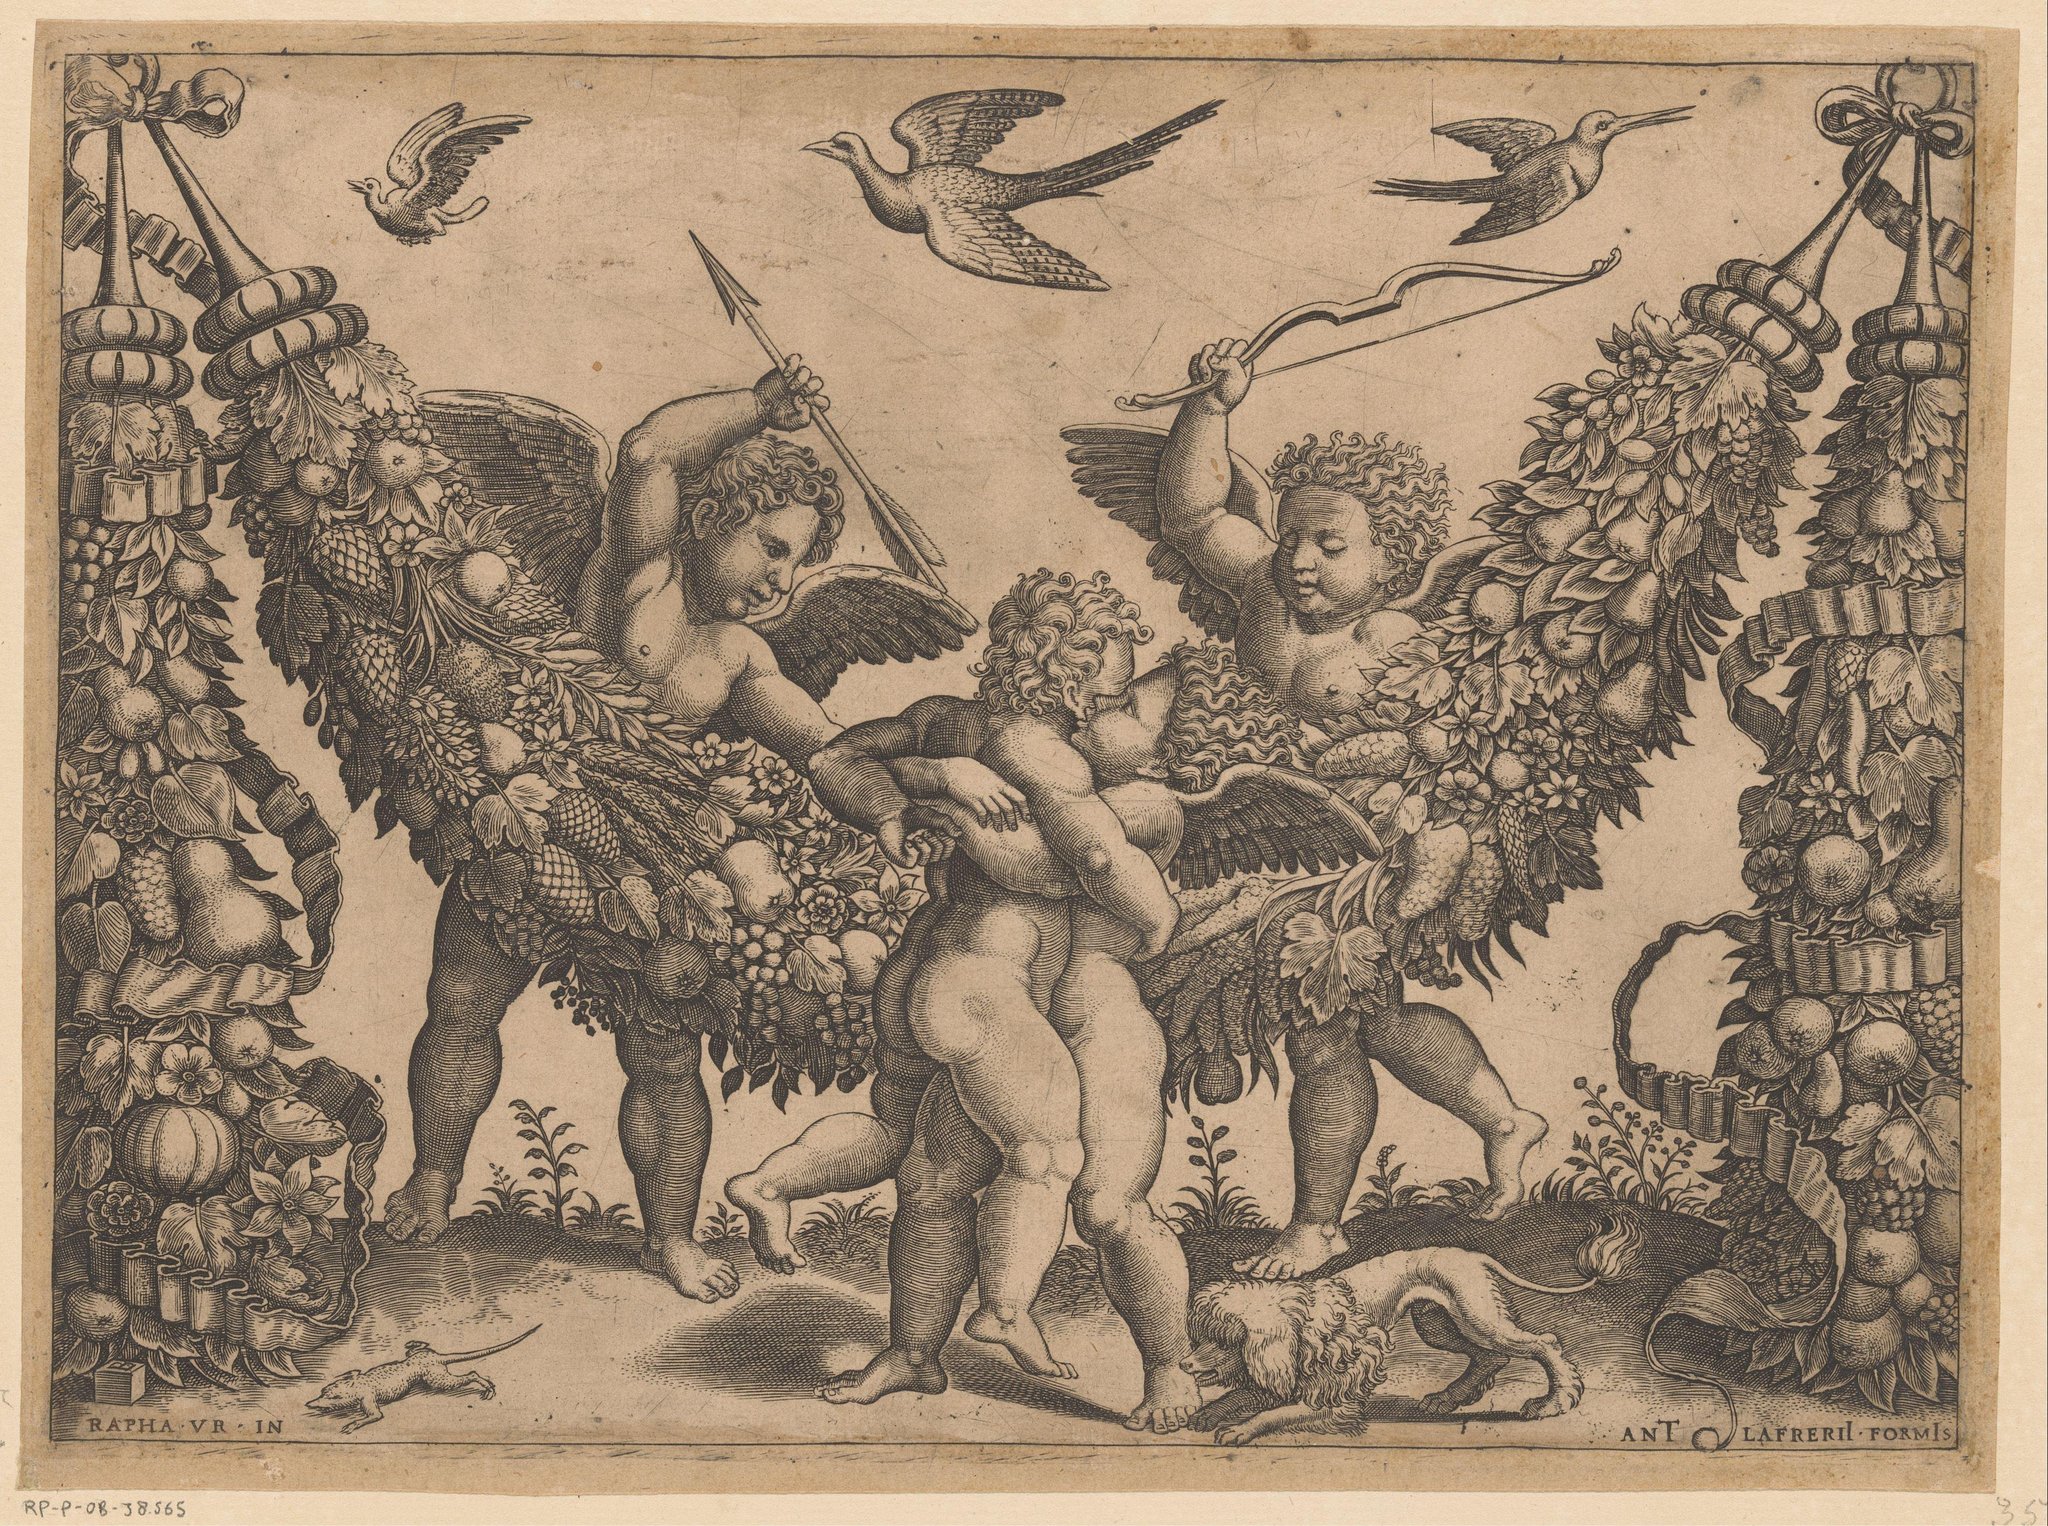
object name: print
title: Drie putti en een kind bij een guirlande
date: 1530-1560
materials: paper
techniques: engraving, intaglio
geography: italy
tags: cupids: 'amores', 'amoretti', 'putti', dog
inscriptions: collector's mark: Lugt 240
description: Voor een grote guirlande tilt een putto een kind op. Achter de guirlande twee putti met pijl-en-boog. In de lucht drie vogels en op de voorgrond een hond.